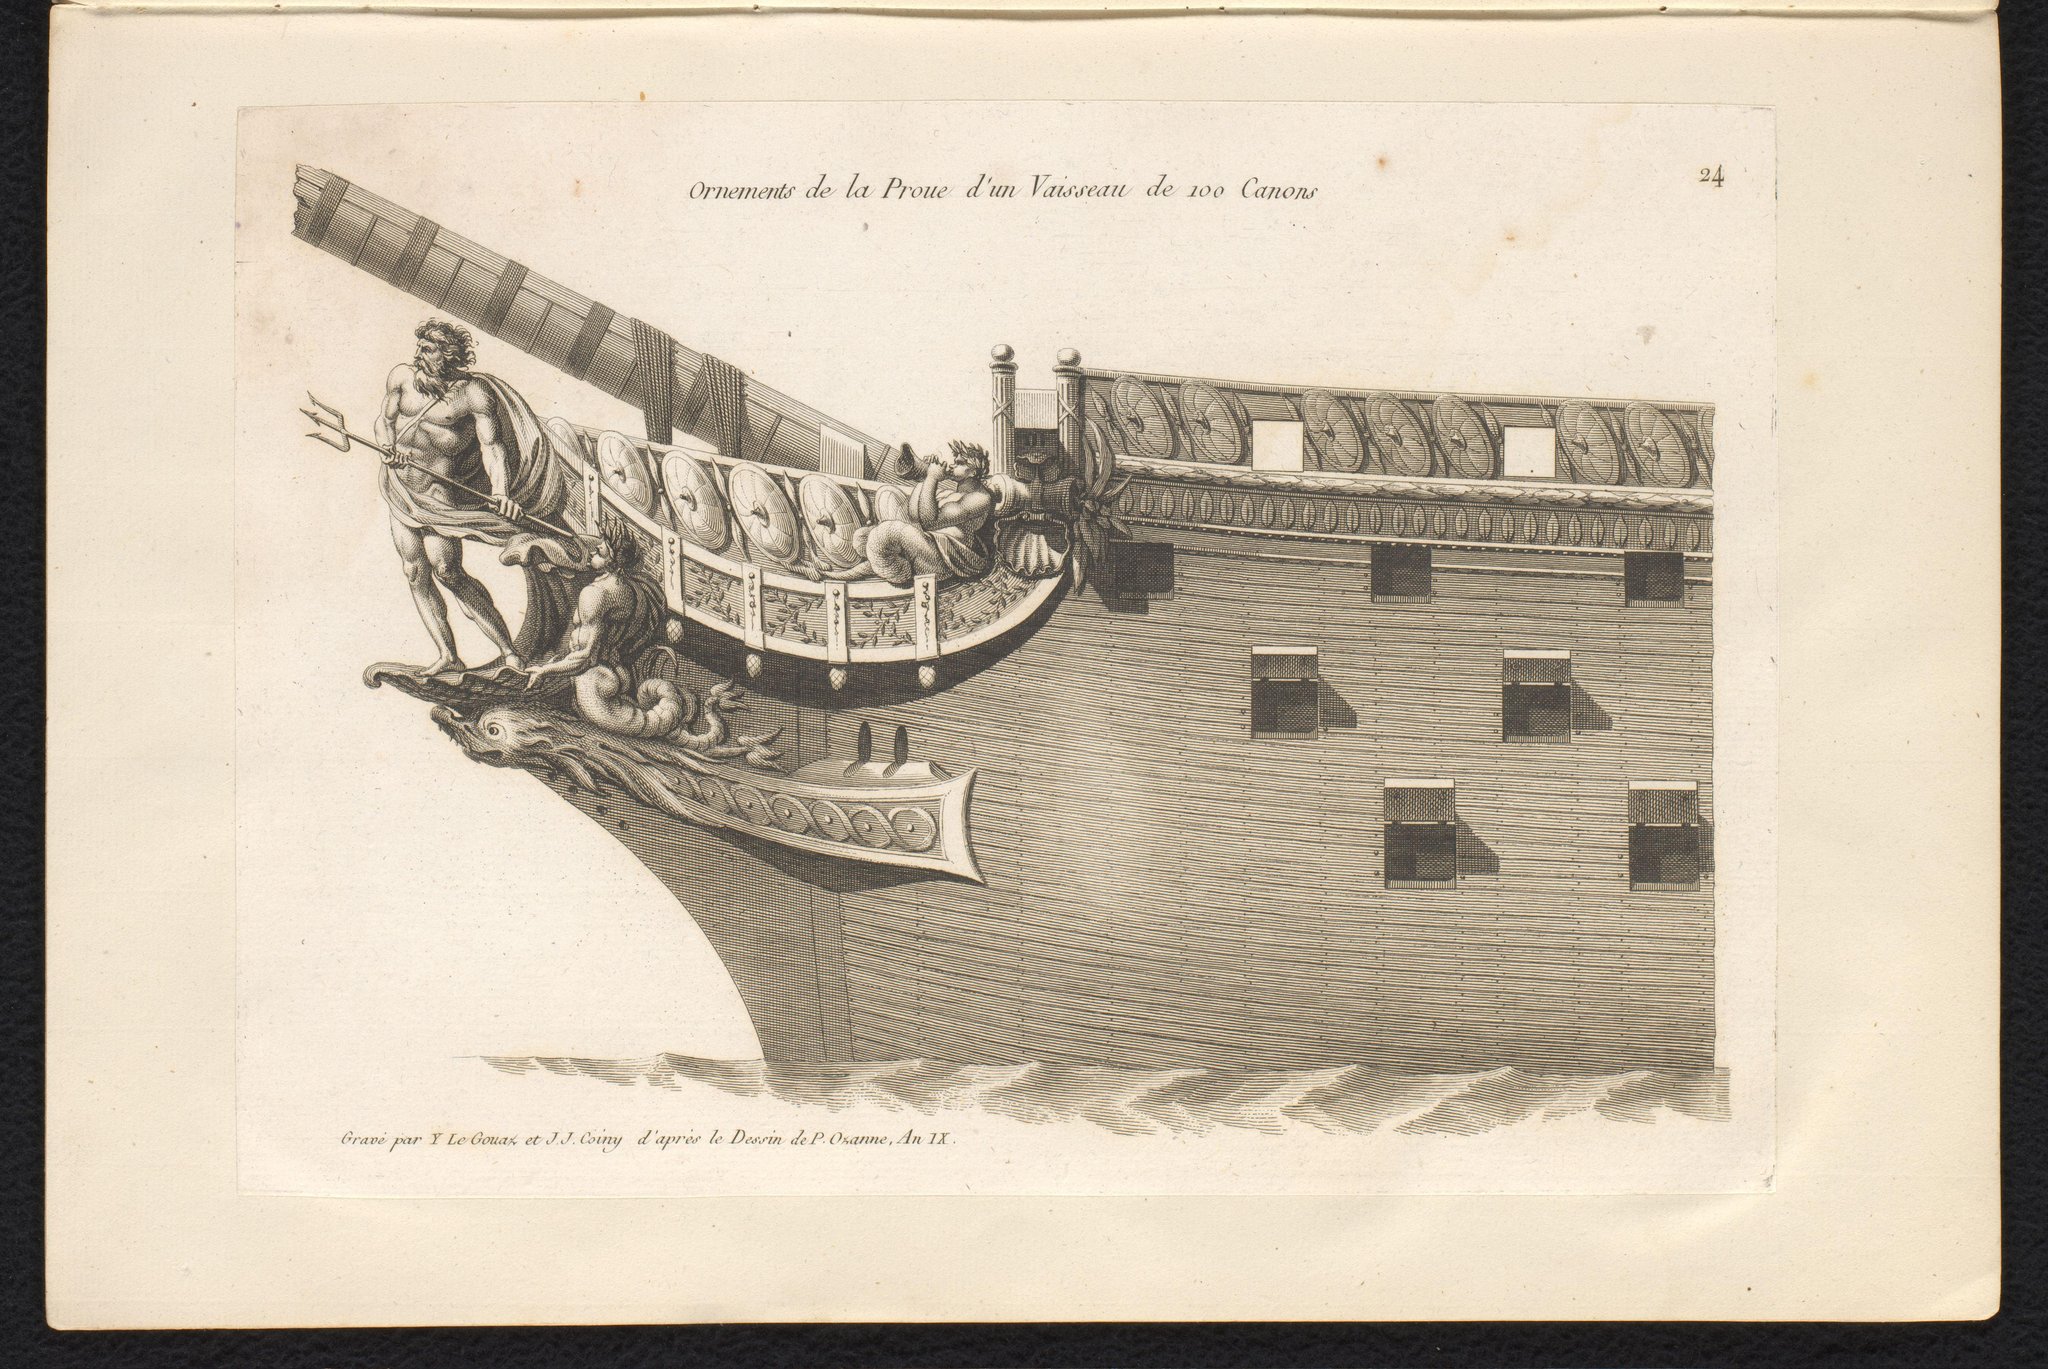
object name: ornament print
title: Ornements de la proue de différents vaisseaux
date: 1800-1801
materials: paper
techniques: engraving, etching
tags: sailing-ship, sailing-boat, parts of ship's exterior: bow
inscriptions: collector's mark: Lugt 2760, collector's mark: Lugt 2228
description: Deze prent maakt deel uit van een album.